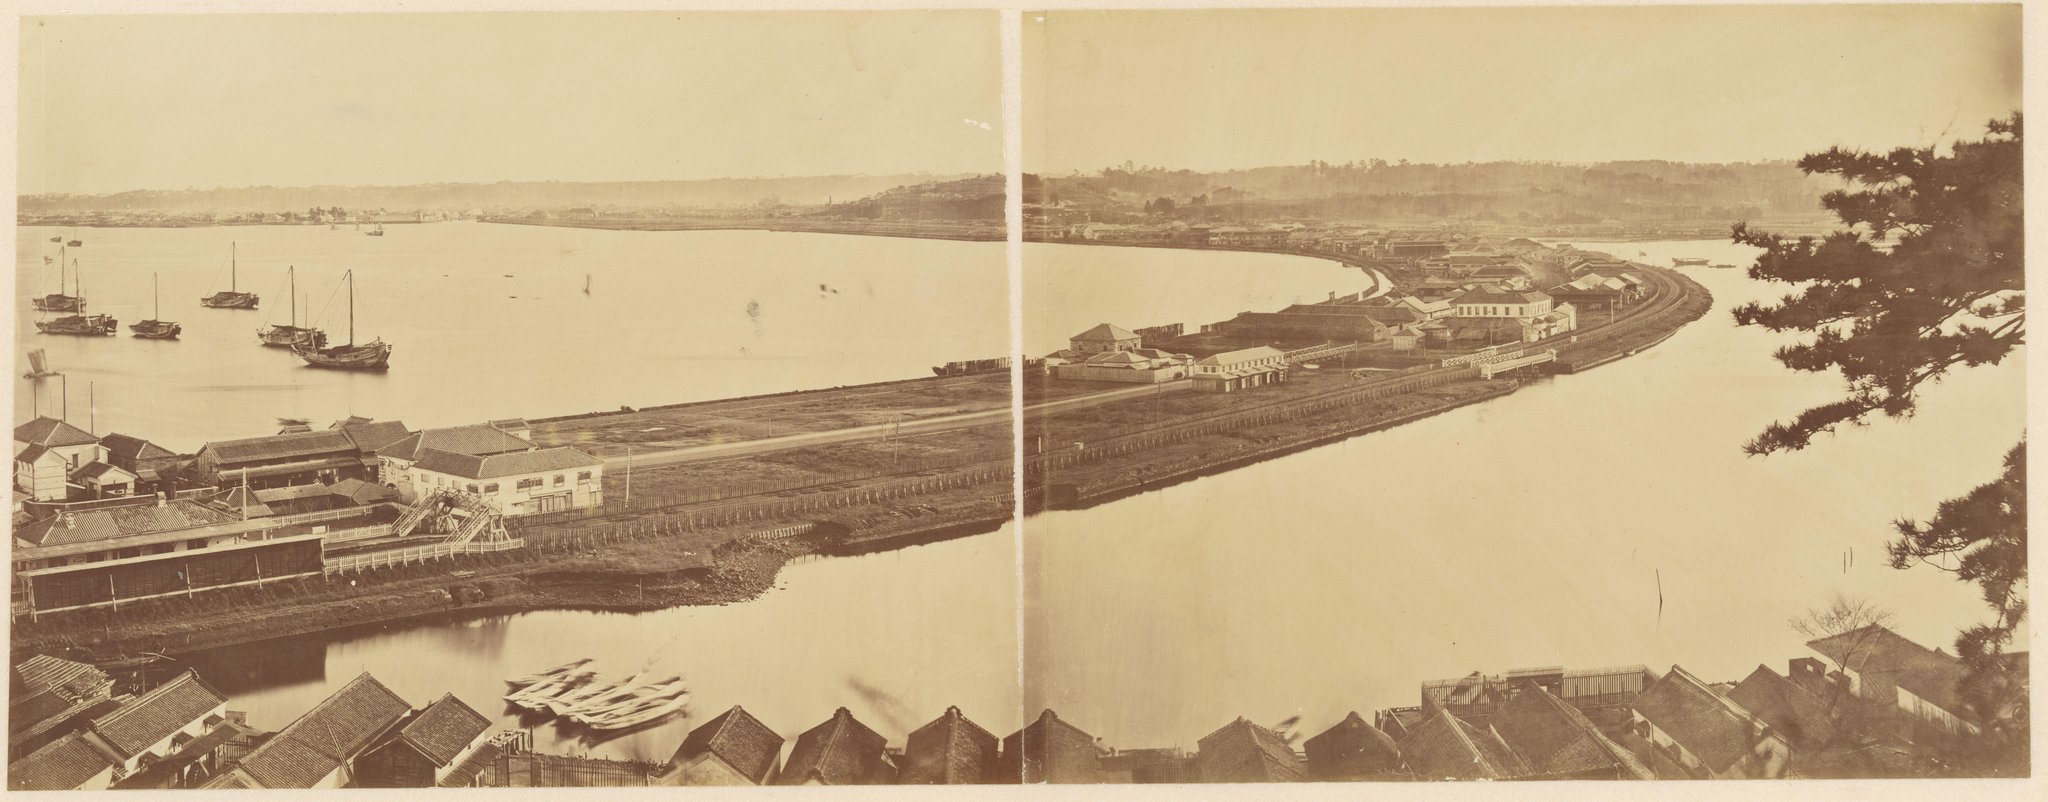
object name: photograph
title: Railway from Kanagawa to Yokohama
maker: Anonymous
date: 1872-1874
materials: paper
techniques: albumen print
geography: japan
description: Both Antoon and Albert visited Yokohama several times. Albert also lived there during his last three years in Japan. As in Nagasaki, he served as the Nederlandse Handel-Maatschappij’s agent and as a consul there. Japan’s first railway was laid between Yokohama and Tokyo and taken into use in 1872. By then, Antoon was back in the Netherlands already, so Albert must have brought this photo home with him.